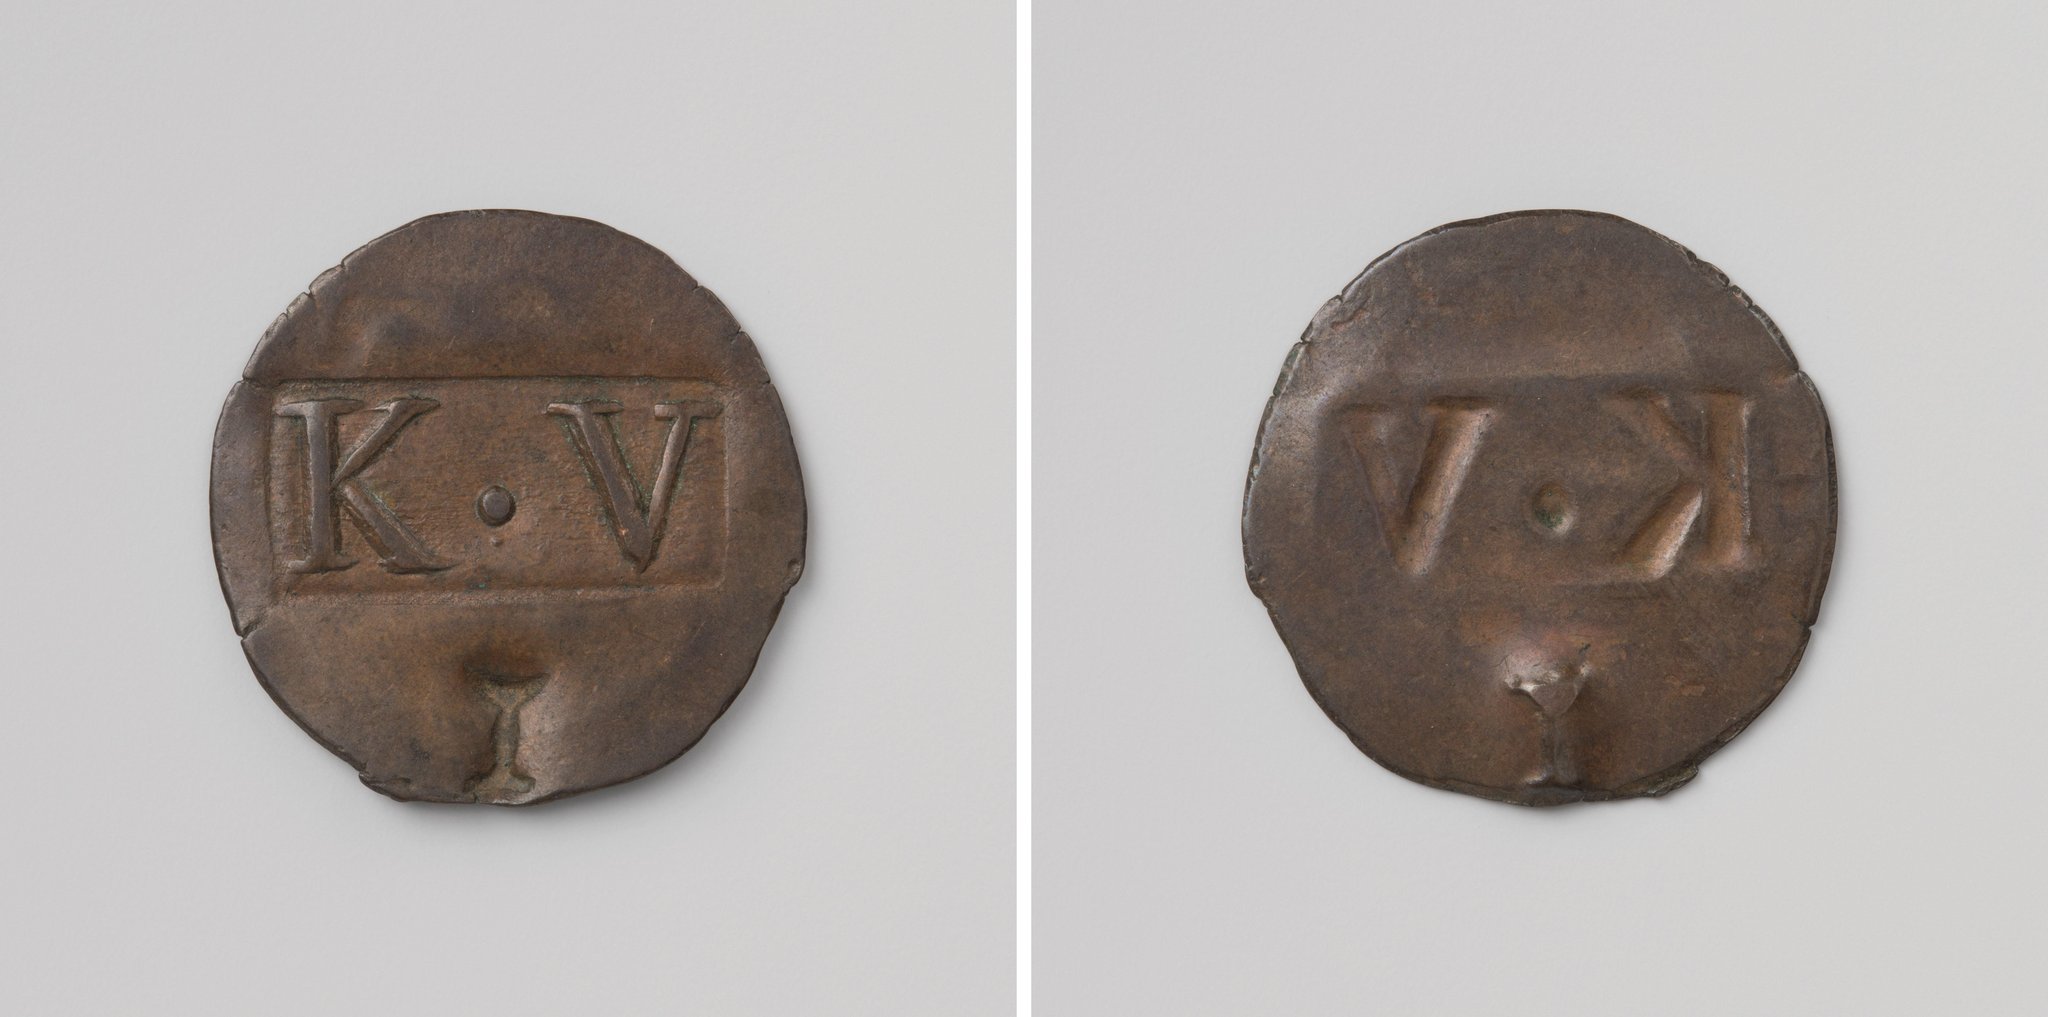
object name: monetary token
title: Kolonie Veenhuizen, huismunt geslagen op last van de Maatschappij van Weldadigheid ter waarde van 1 cent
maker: Anonymous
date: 1818-1859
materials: copper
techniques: striking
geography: netherlands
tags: maatschappij van weldadigheid, veenhuizen